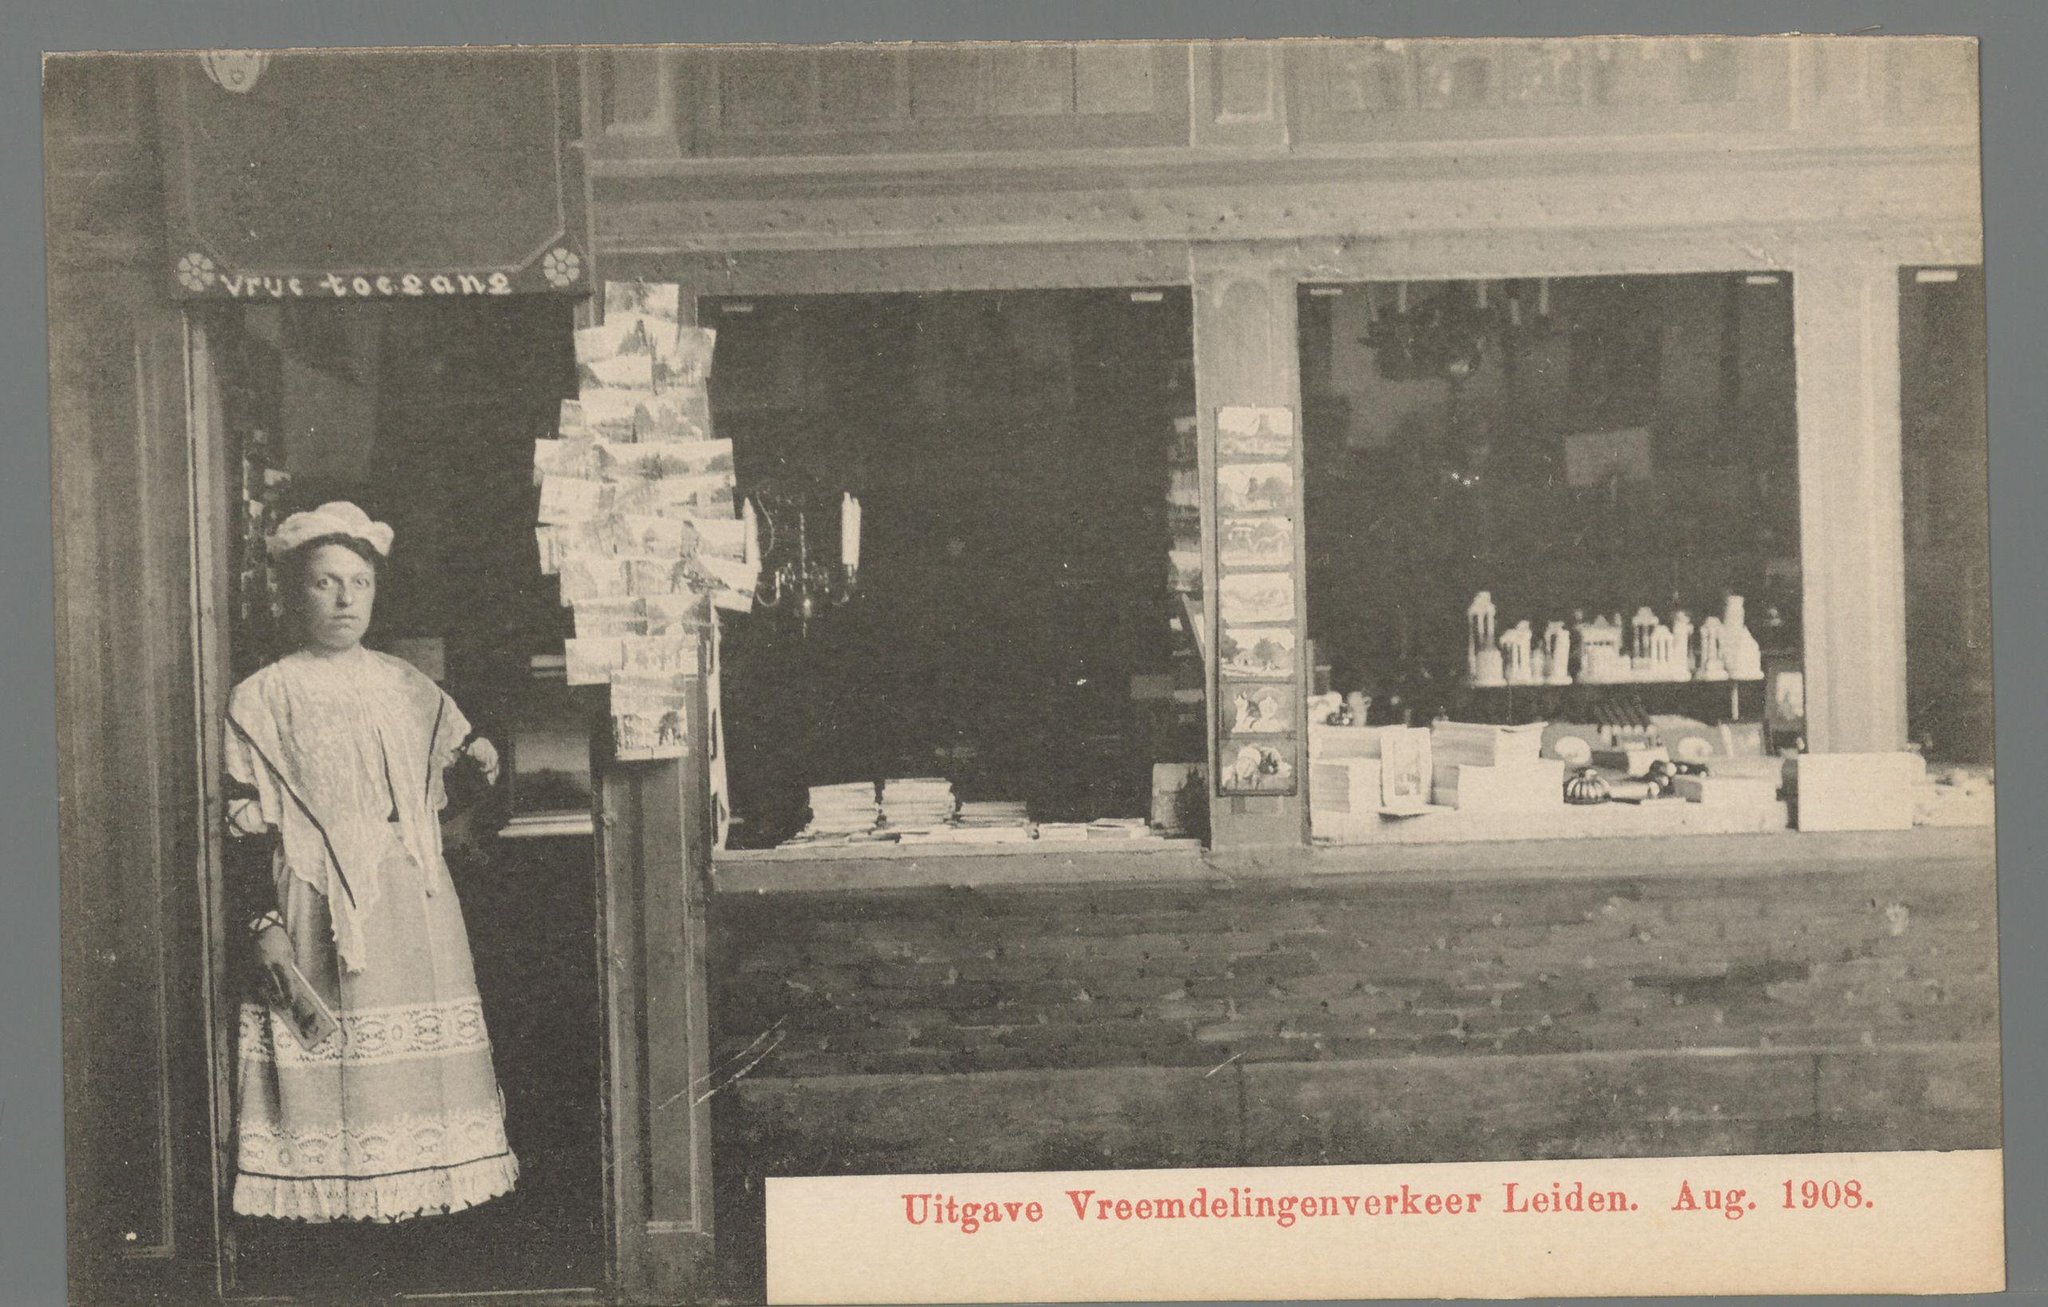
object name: photomechanical print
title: Vrouw in kostuum voor een winkel tijdens de Oud-Hollandse feesten te Leiden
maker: Anonymous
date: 1908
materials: cardboard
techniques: photograph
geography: haarlem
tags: shop, store, dress-up party, festivities, leiden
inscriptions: date